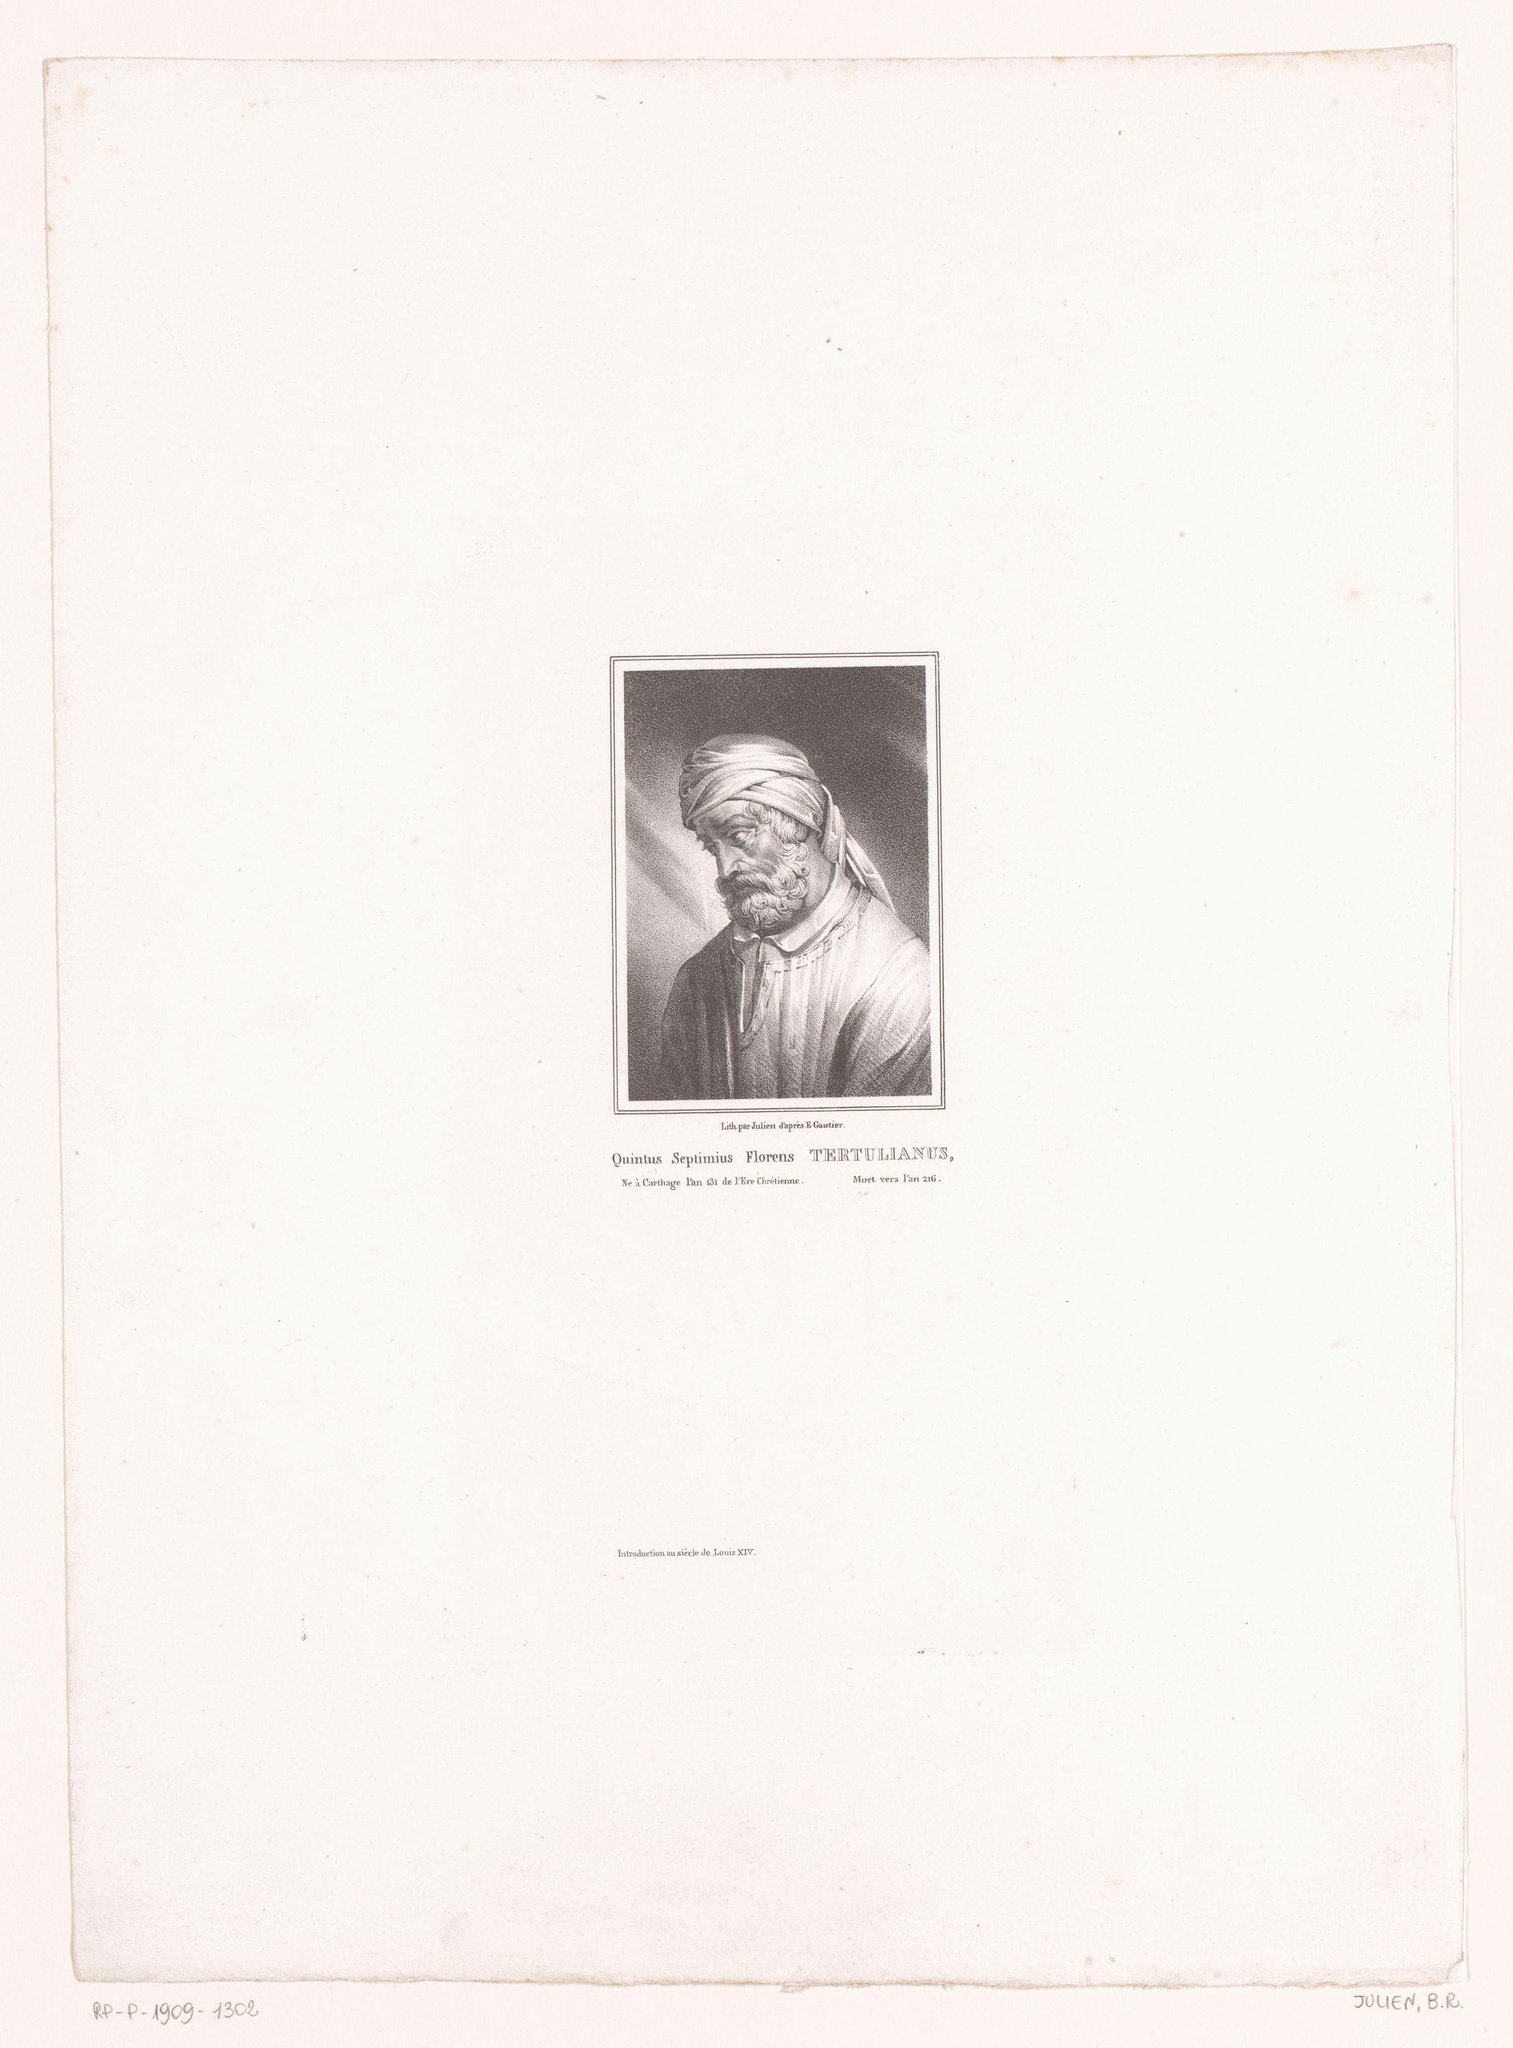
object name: print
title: Portrettengalerij van schrijvers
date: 1830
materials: paper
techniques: lithograph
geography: paris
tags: historical persons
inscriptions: collector's mark: Lugt 2228a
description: Prent gebruikt voor: Illustrations du Cours de Littérature de la Harpe, ou collection de 400 portraits destinés à l'ornement de cet ouvrage. Parijs: Boblet, 1830.